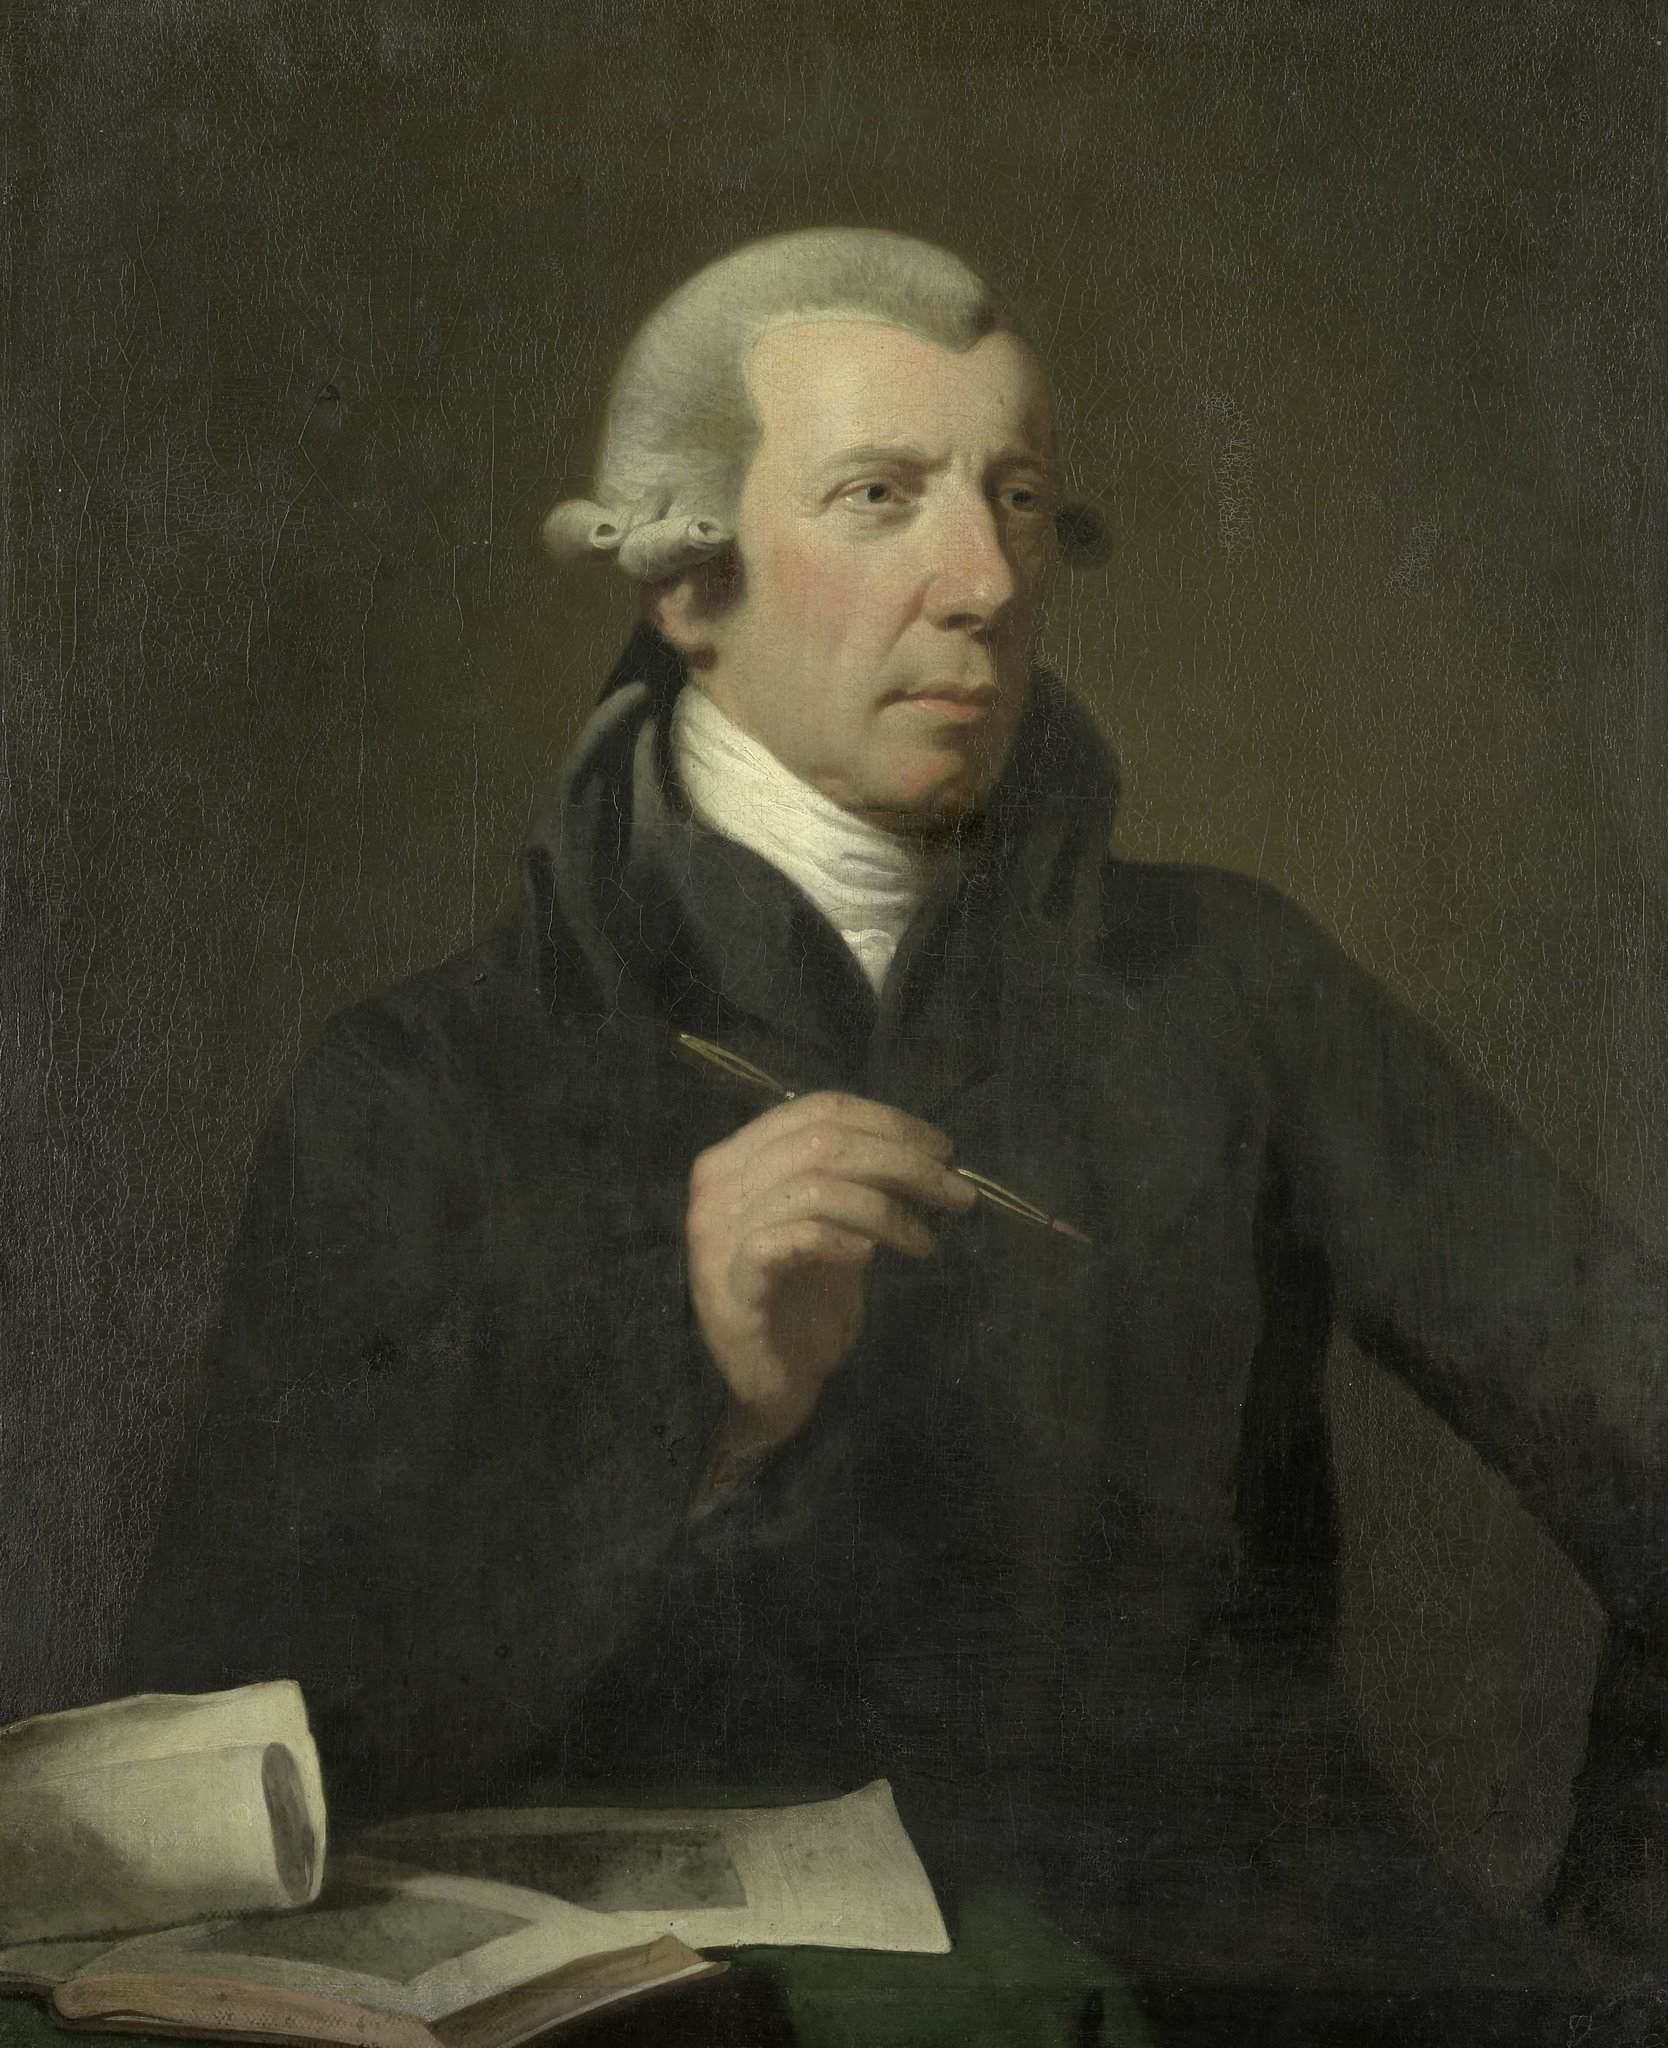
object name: painting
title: Reinier Vinkeles (1741-1816), Draftsman and Engraver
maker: charles howard hodges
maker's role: draughtsman, painter, print maker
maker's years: 1764-1837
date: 1800-1816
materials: canvas, oil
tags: reinier vinkeles (i), historical persons, portrait, self-portrait of artist, portrait, self-portrait of graphic artist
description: Portret van Reinier Vinkeles, tekenaar en plaatsnijder. Borstbeeld, zittend aan een tafel waarop een schetsboek of prentenboek een opgerolde blad papier en een tekening of prent. In de rechterhand een koperen tekenpen of graveerstift.